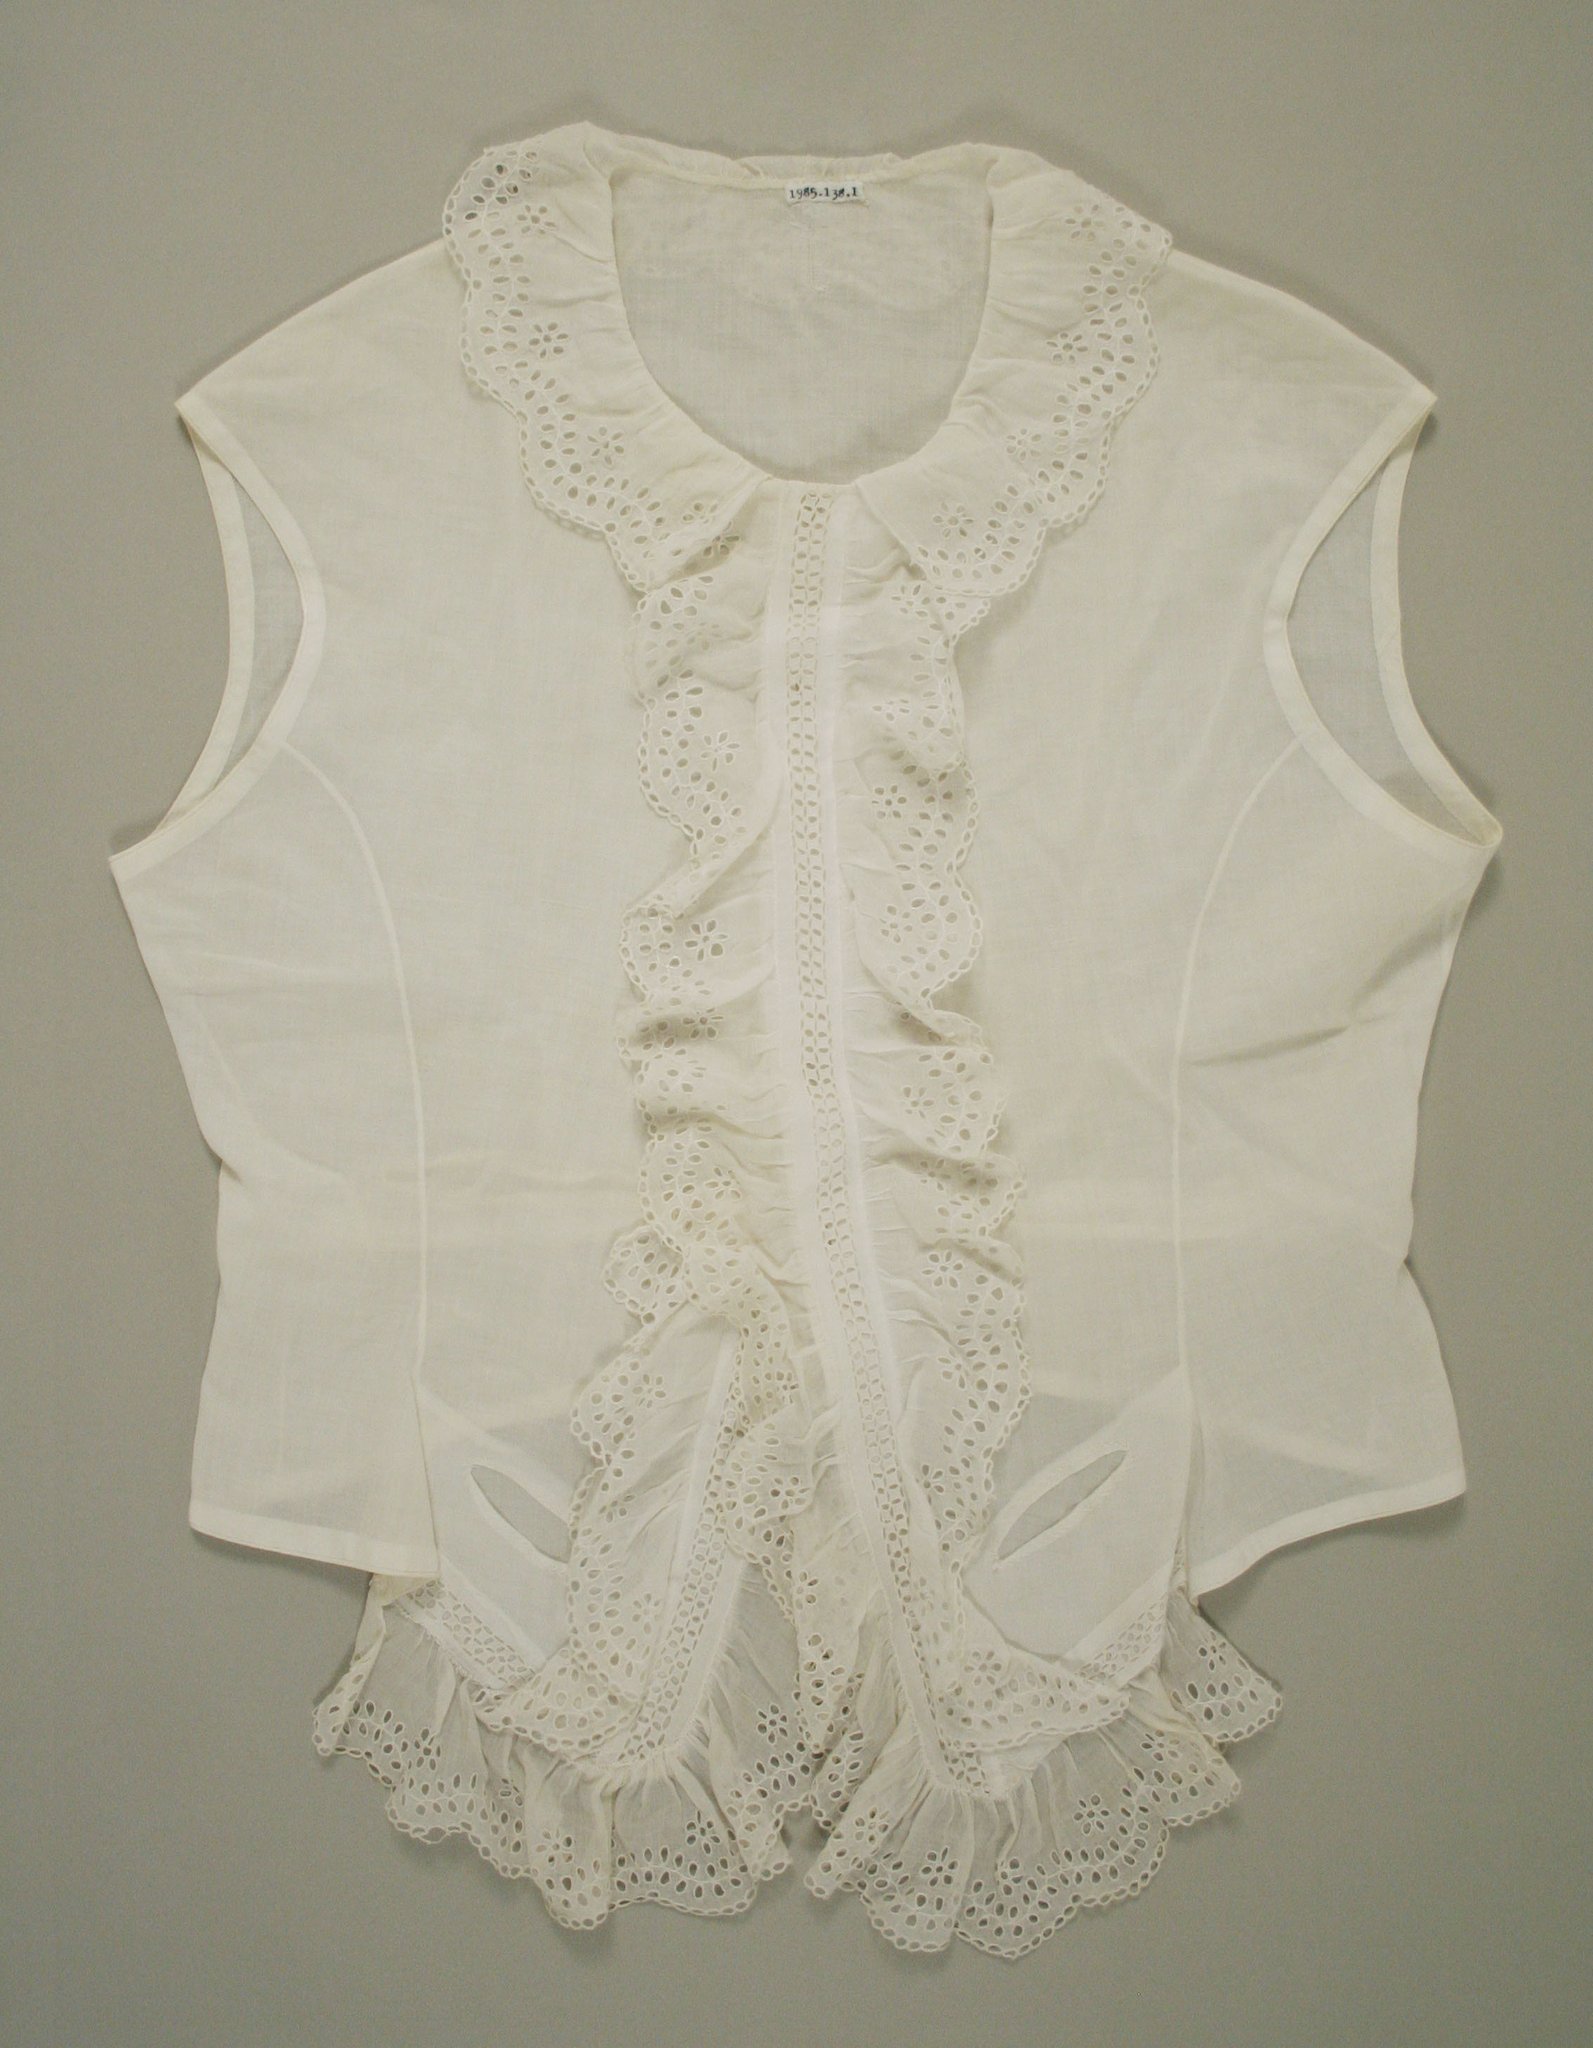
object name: dickey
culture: british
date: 1852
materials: cotton